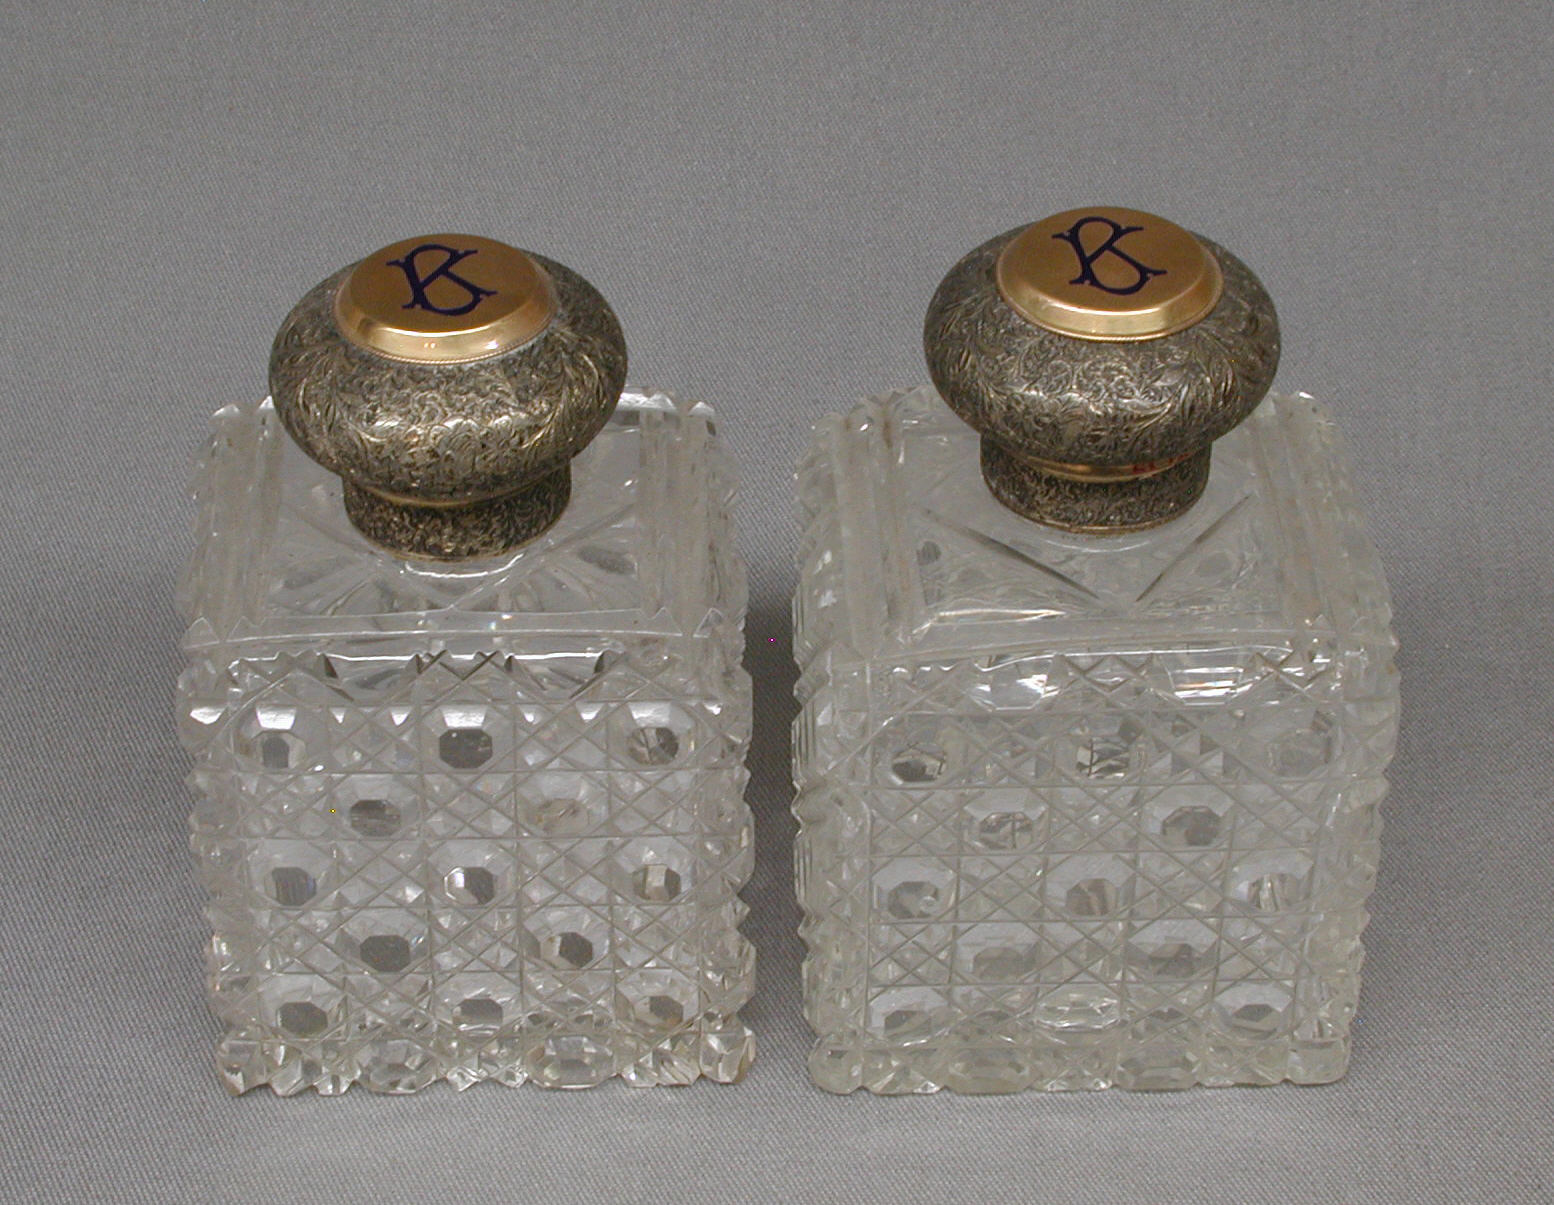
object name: bottle with cover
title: Square bottle with cover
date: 1874-1875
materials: glass, silver